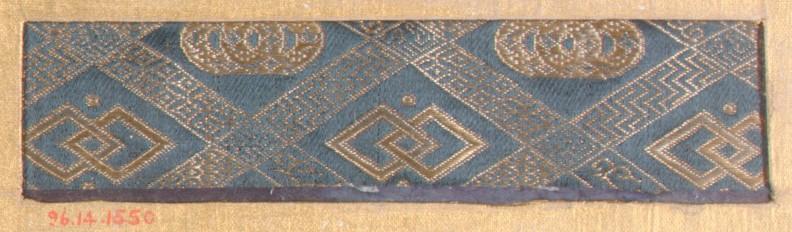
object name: piece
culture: japanese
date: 1701-1900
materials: silk